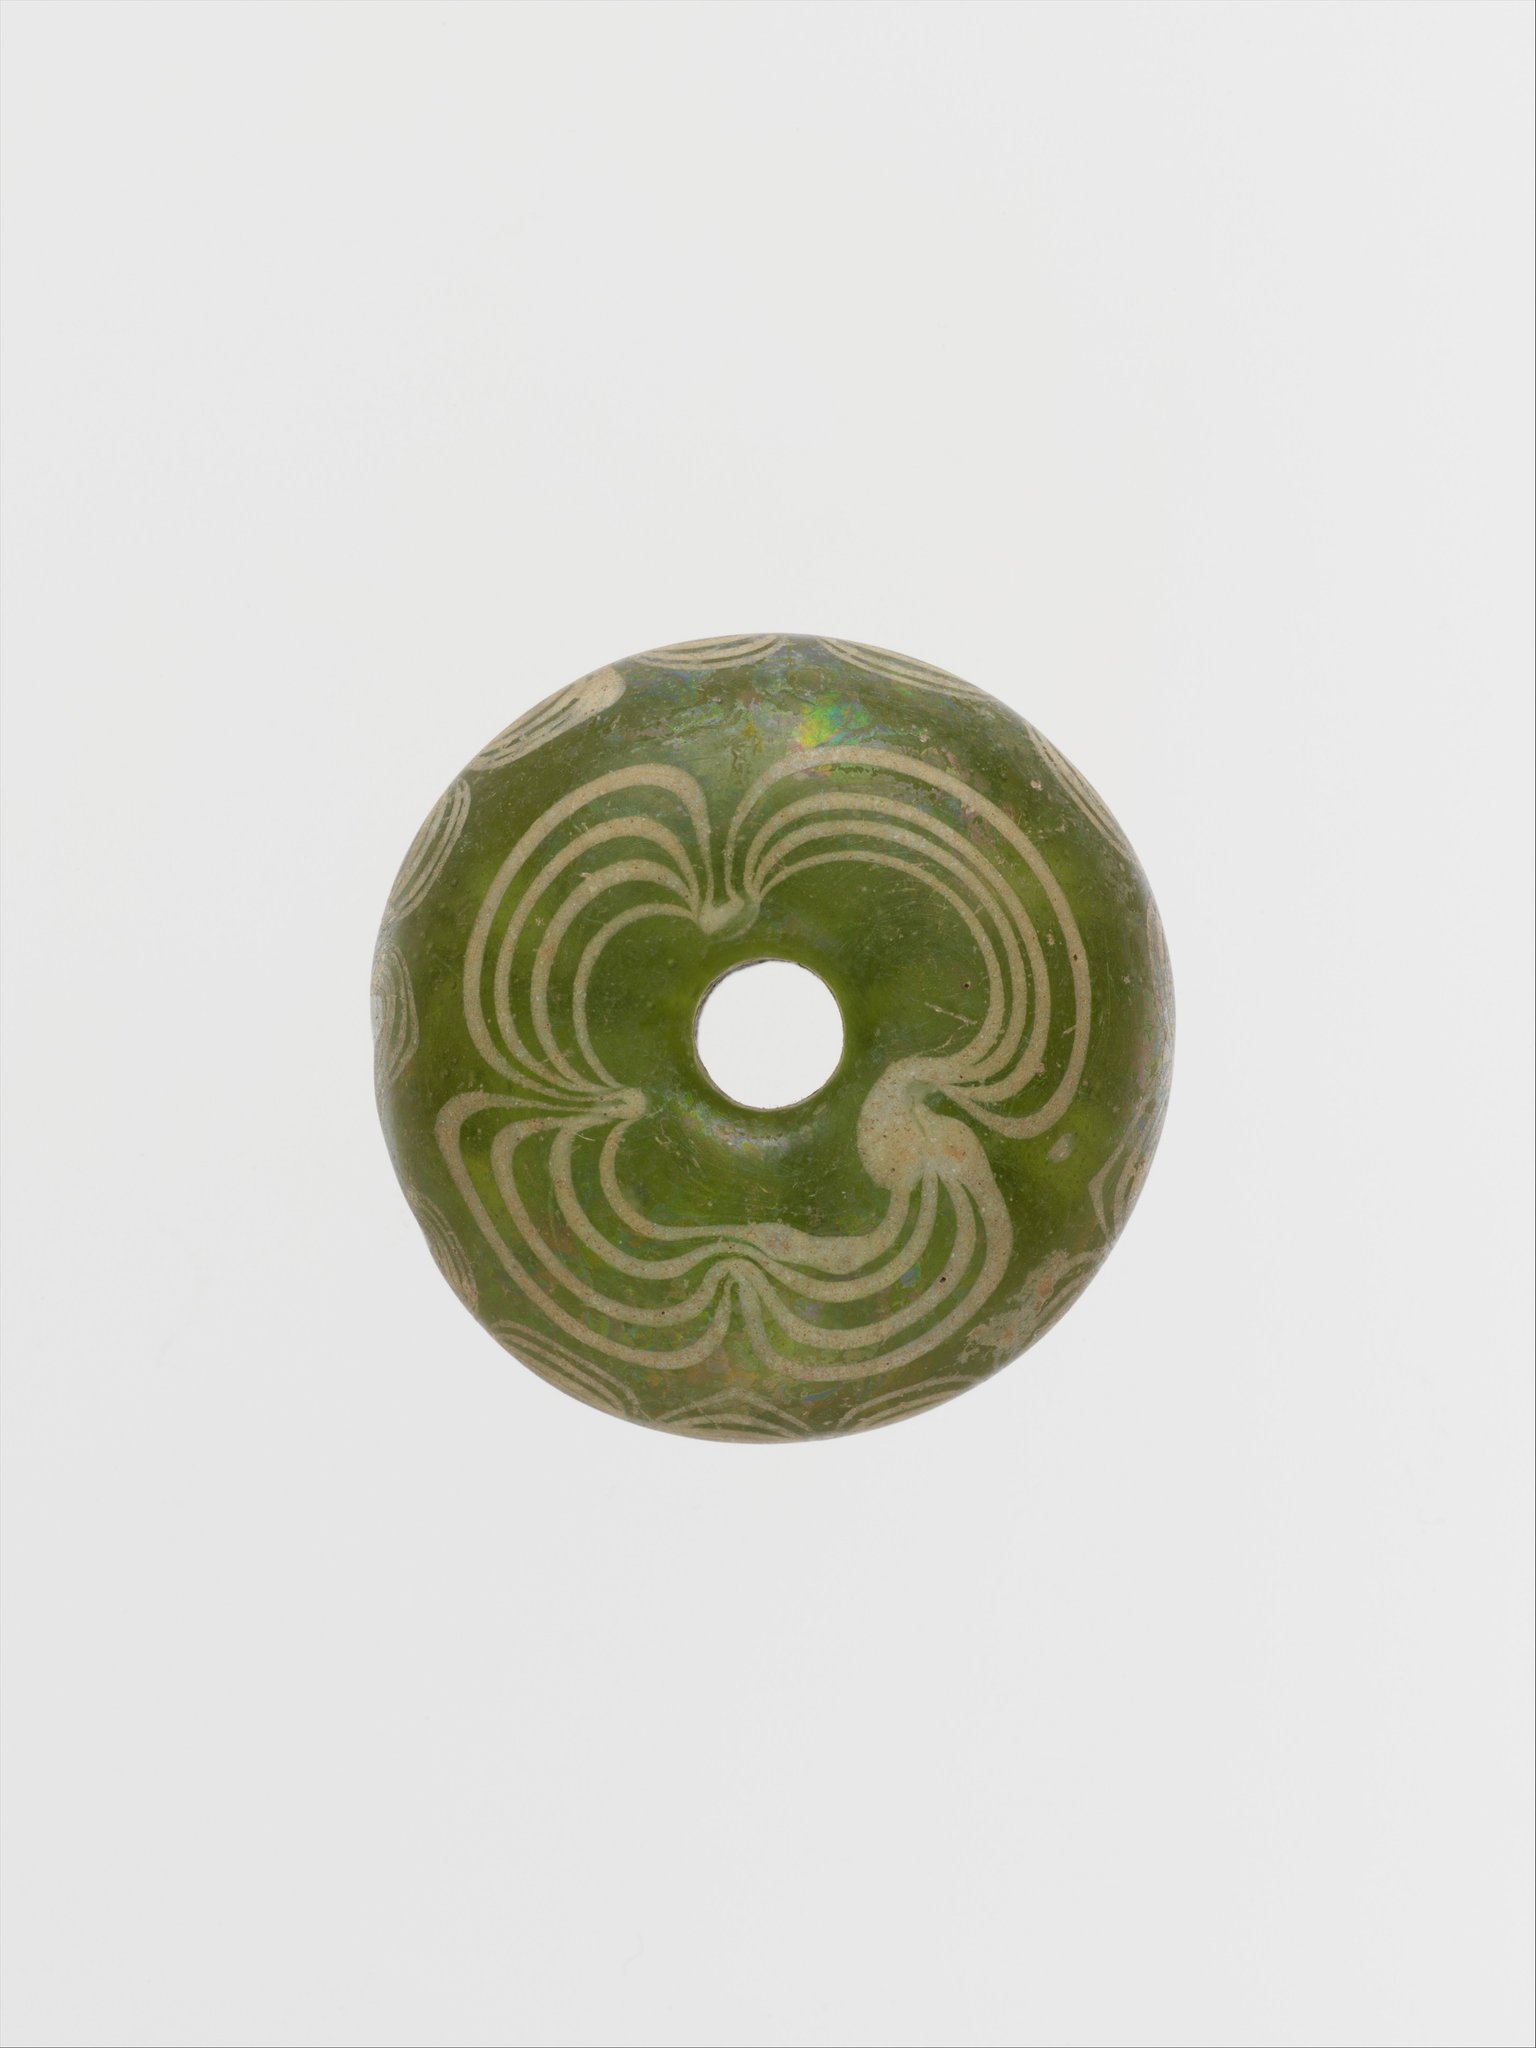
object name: bead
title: Glass whorl or bead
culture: frankish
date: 401-700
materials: glass